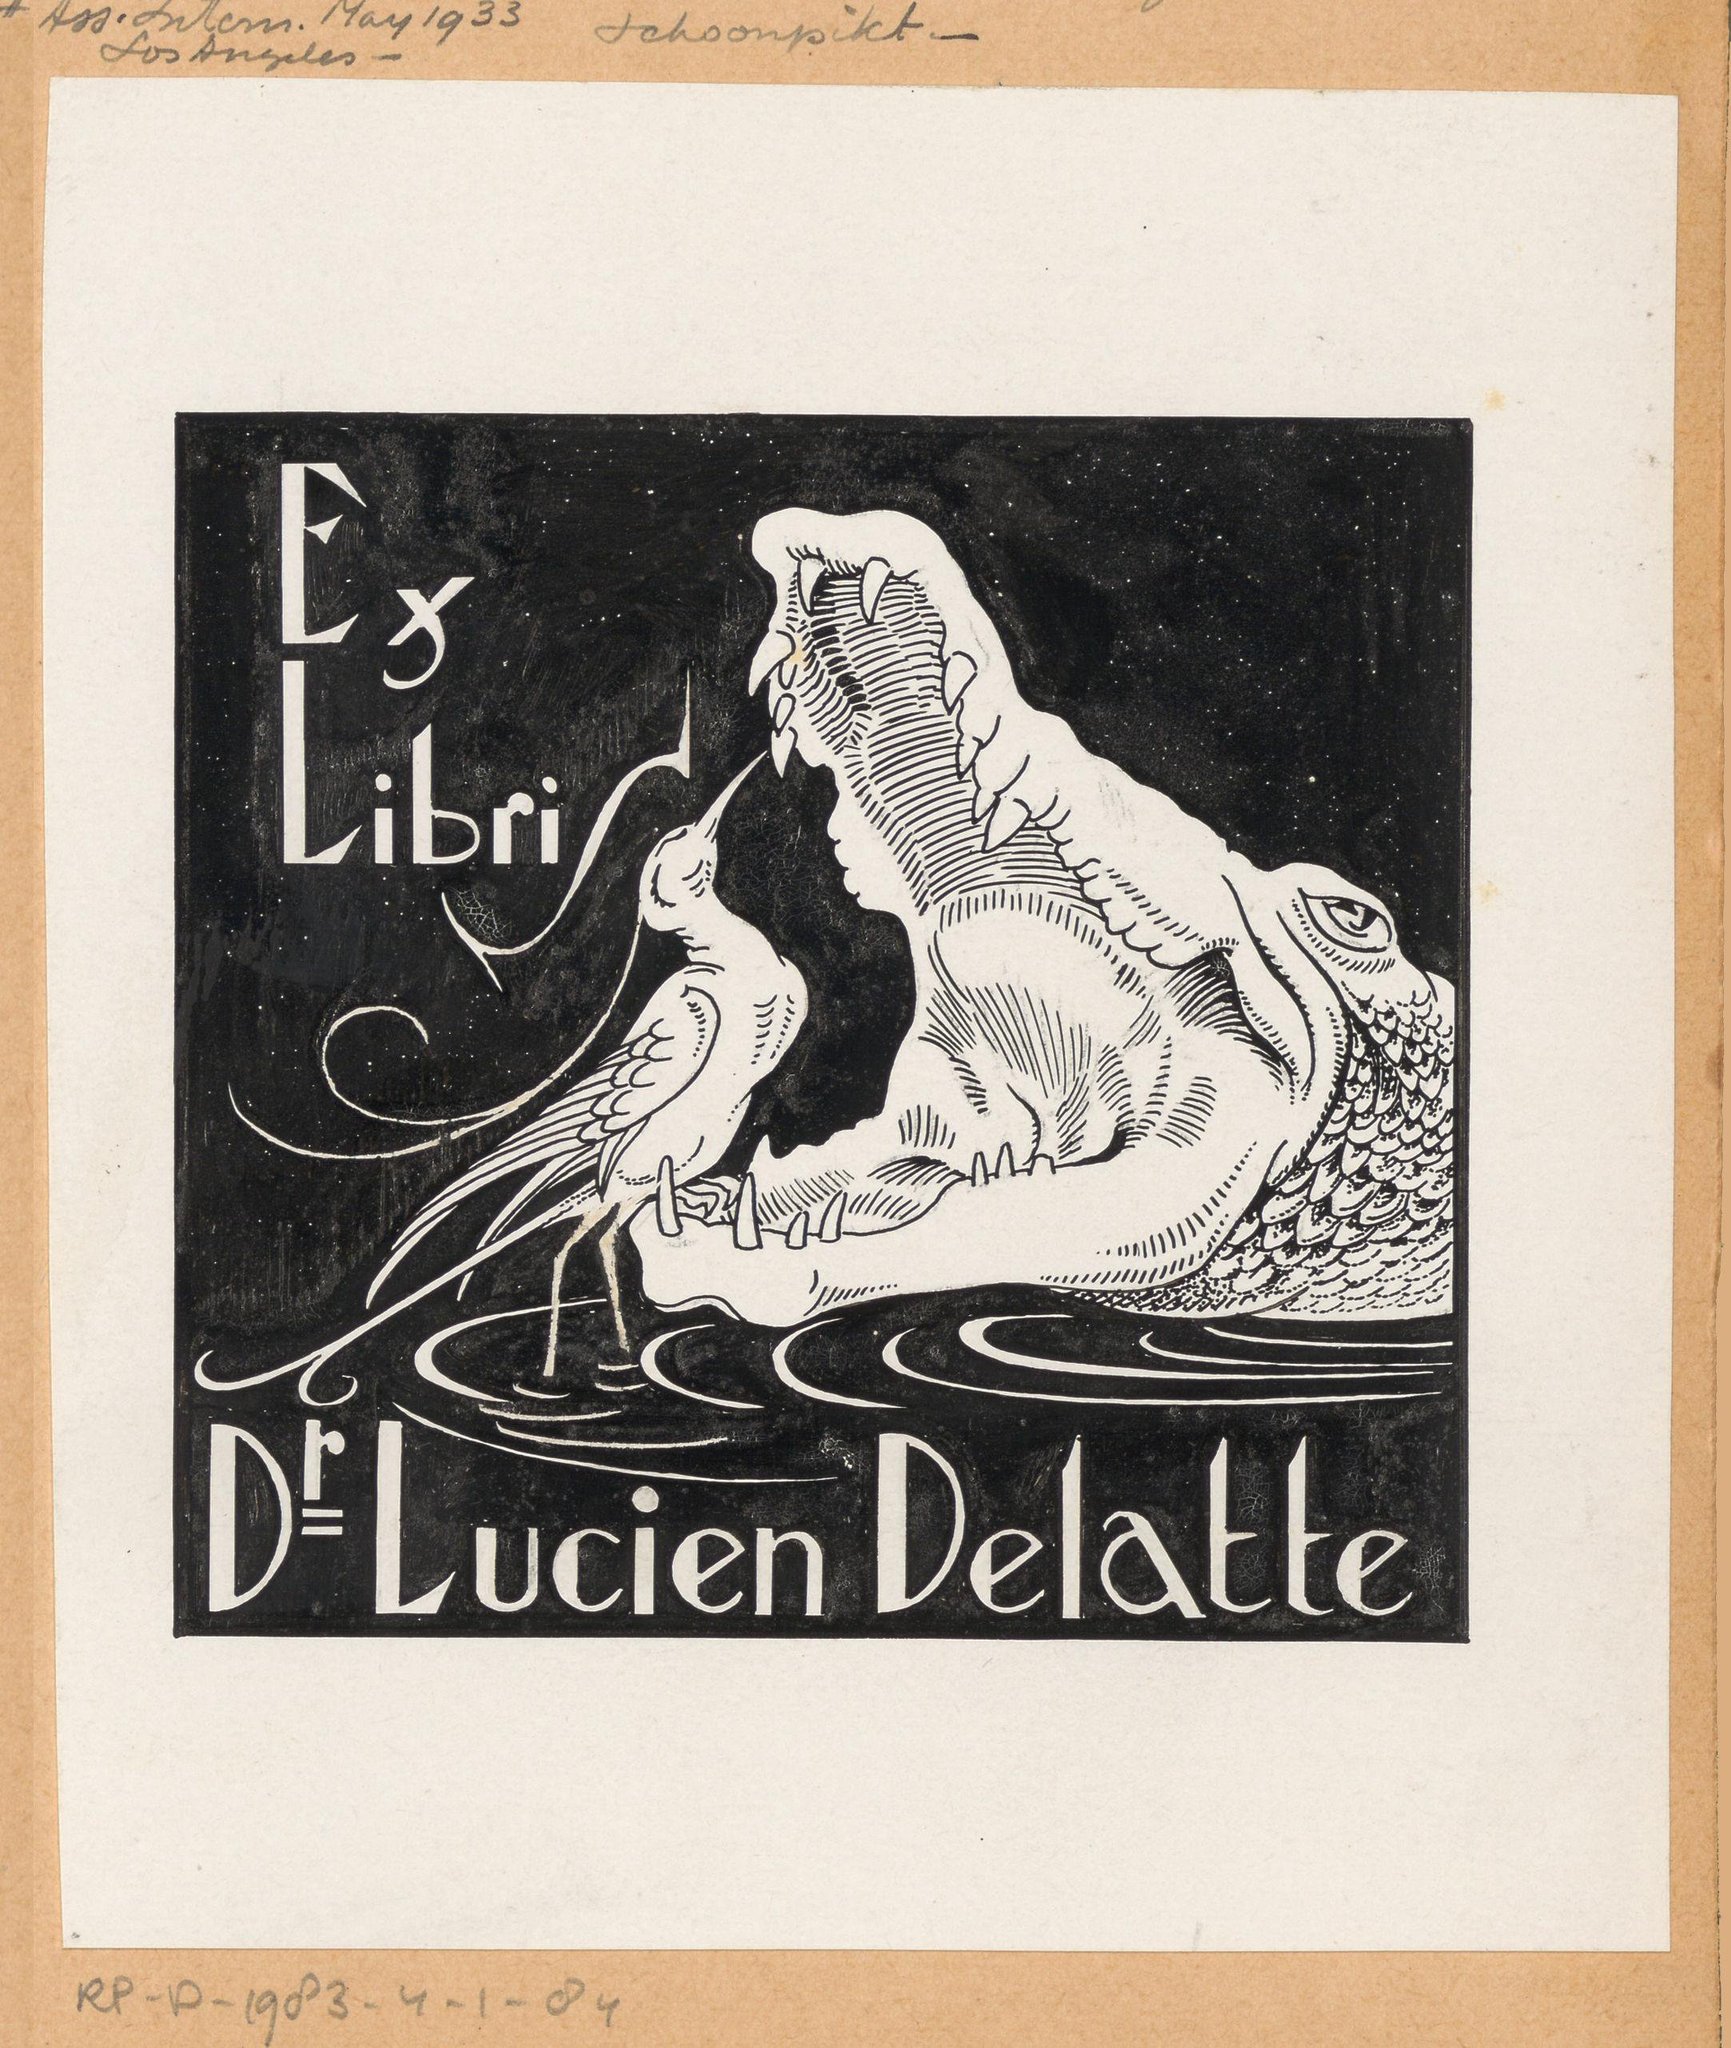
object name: bookplate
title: Ex libris dr. Lucien Delatte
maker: otto verhagen (i)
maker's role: draughtsman, print maker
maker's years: 1885-1951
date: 1933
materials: ink, paper, pencil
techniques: drawing, pen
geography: netherlands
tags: crocodiles: crocodile, birds